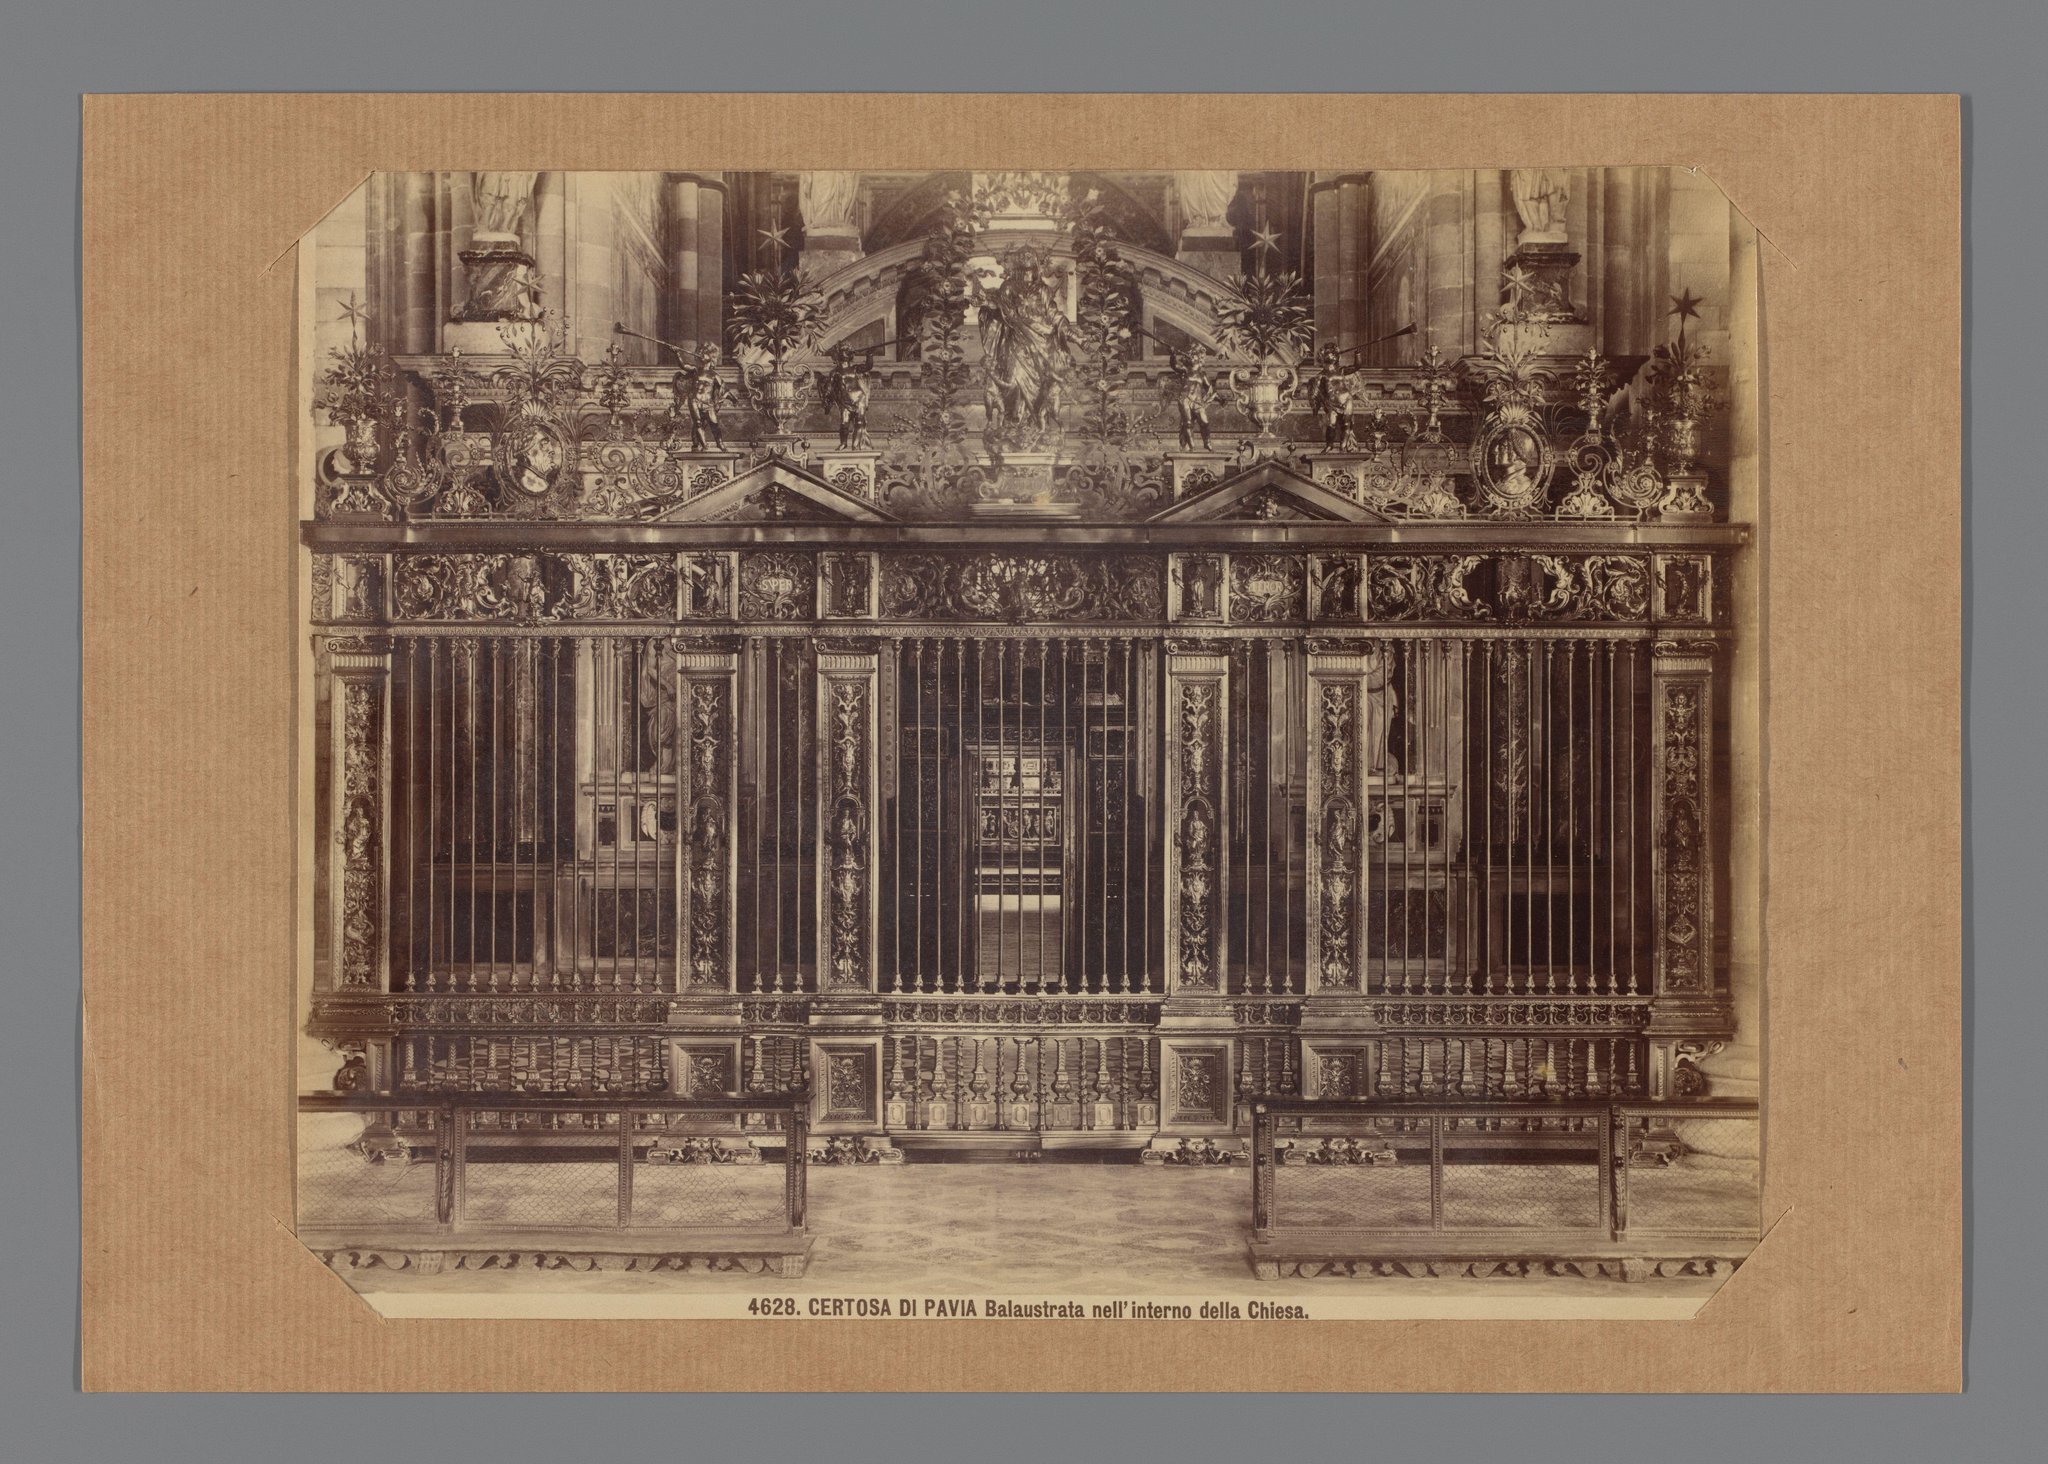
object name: photograph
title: Italië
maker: Anonymous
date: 1880-1910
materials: photographic support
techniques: albumen print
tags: italy